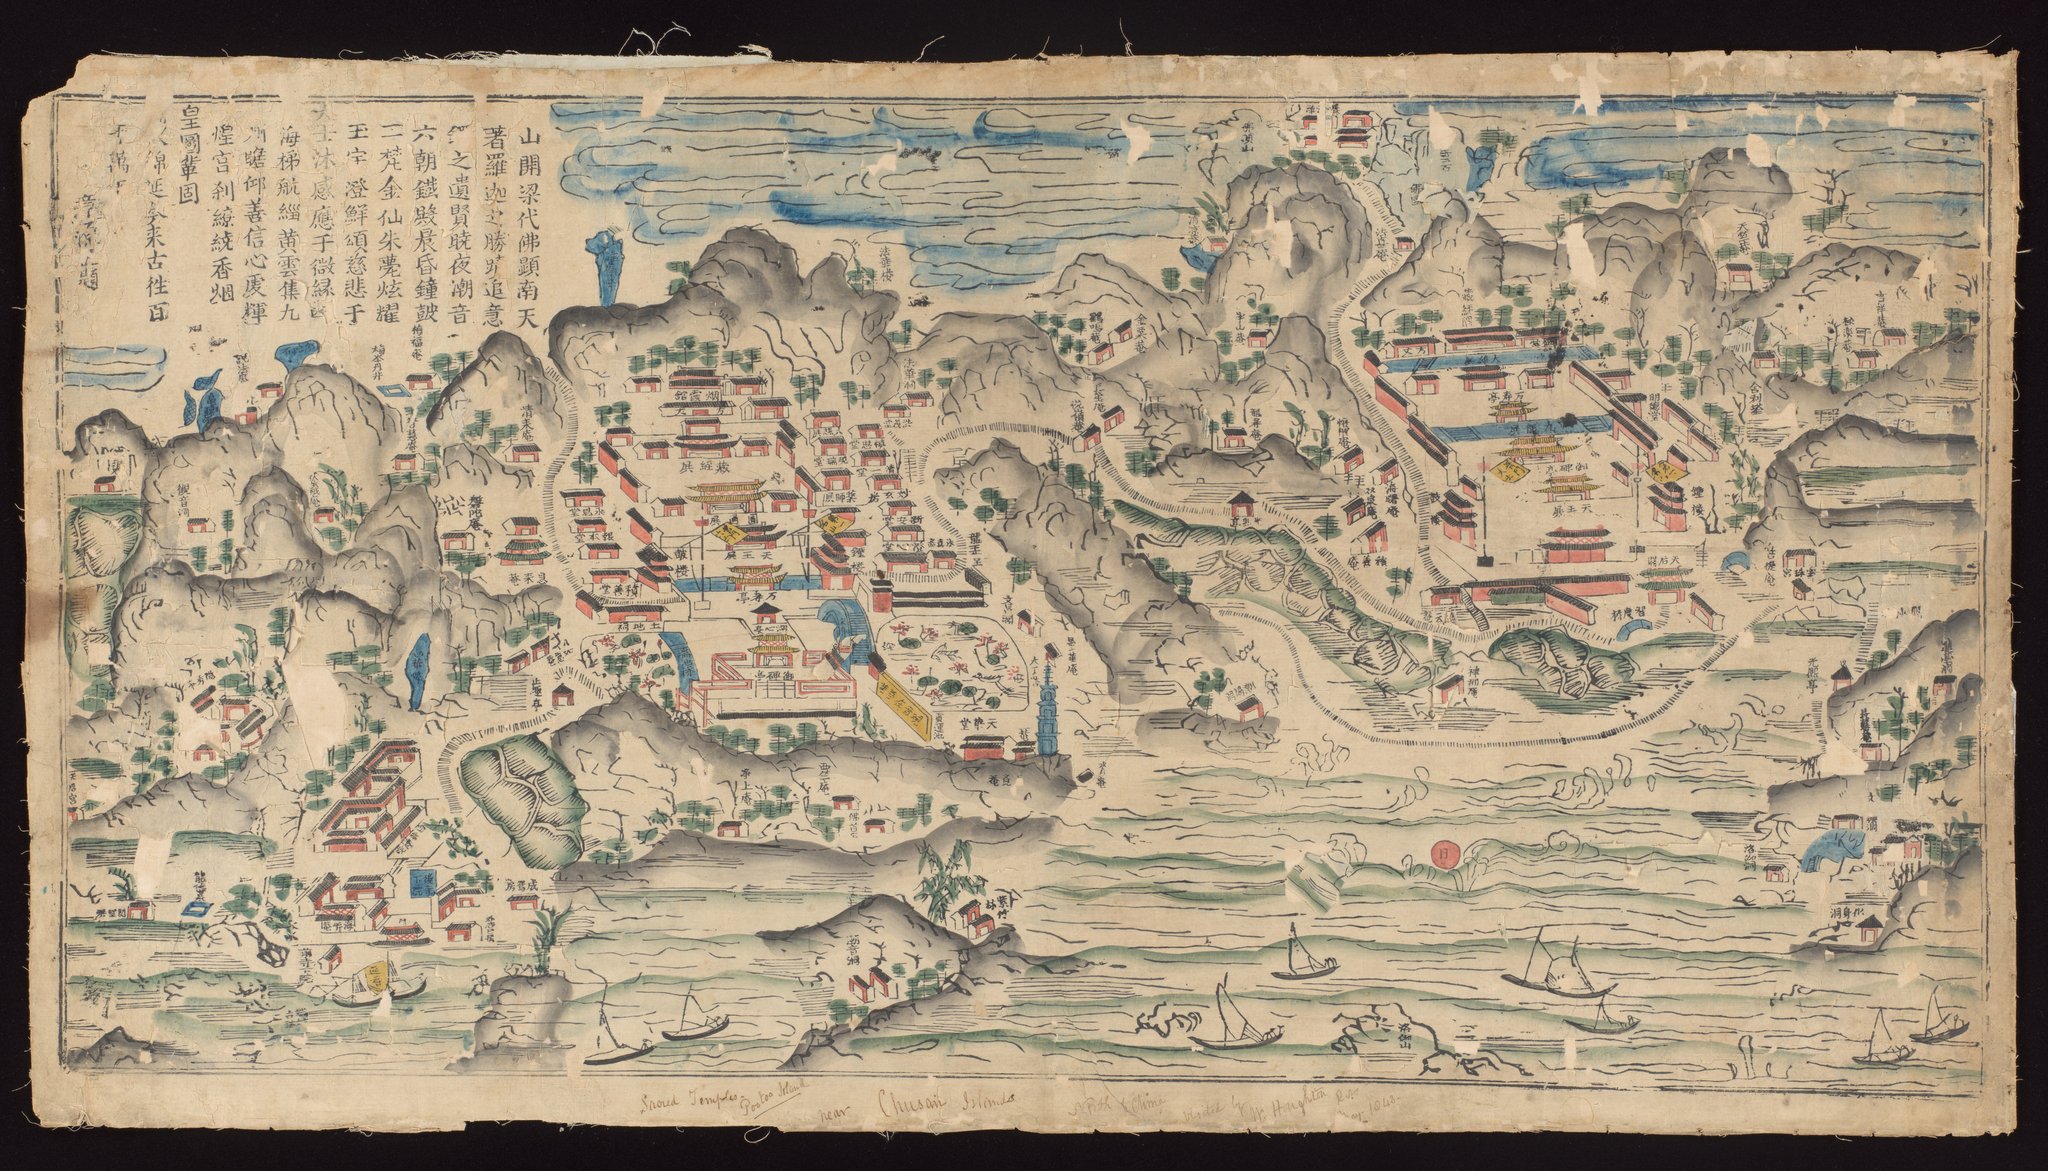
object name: print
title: View of Putuoshan on the Southern Sea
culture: chinese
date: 1796-1820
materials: ink, paper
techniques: hand coloring, woodblock print